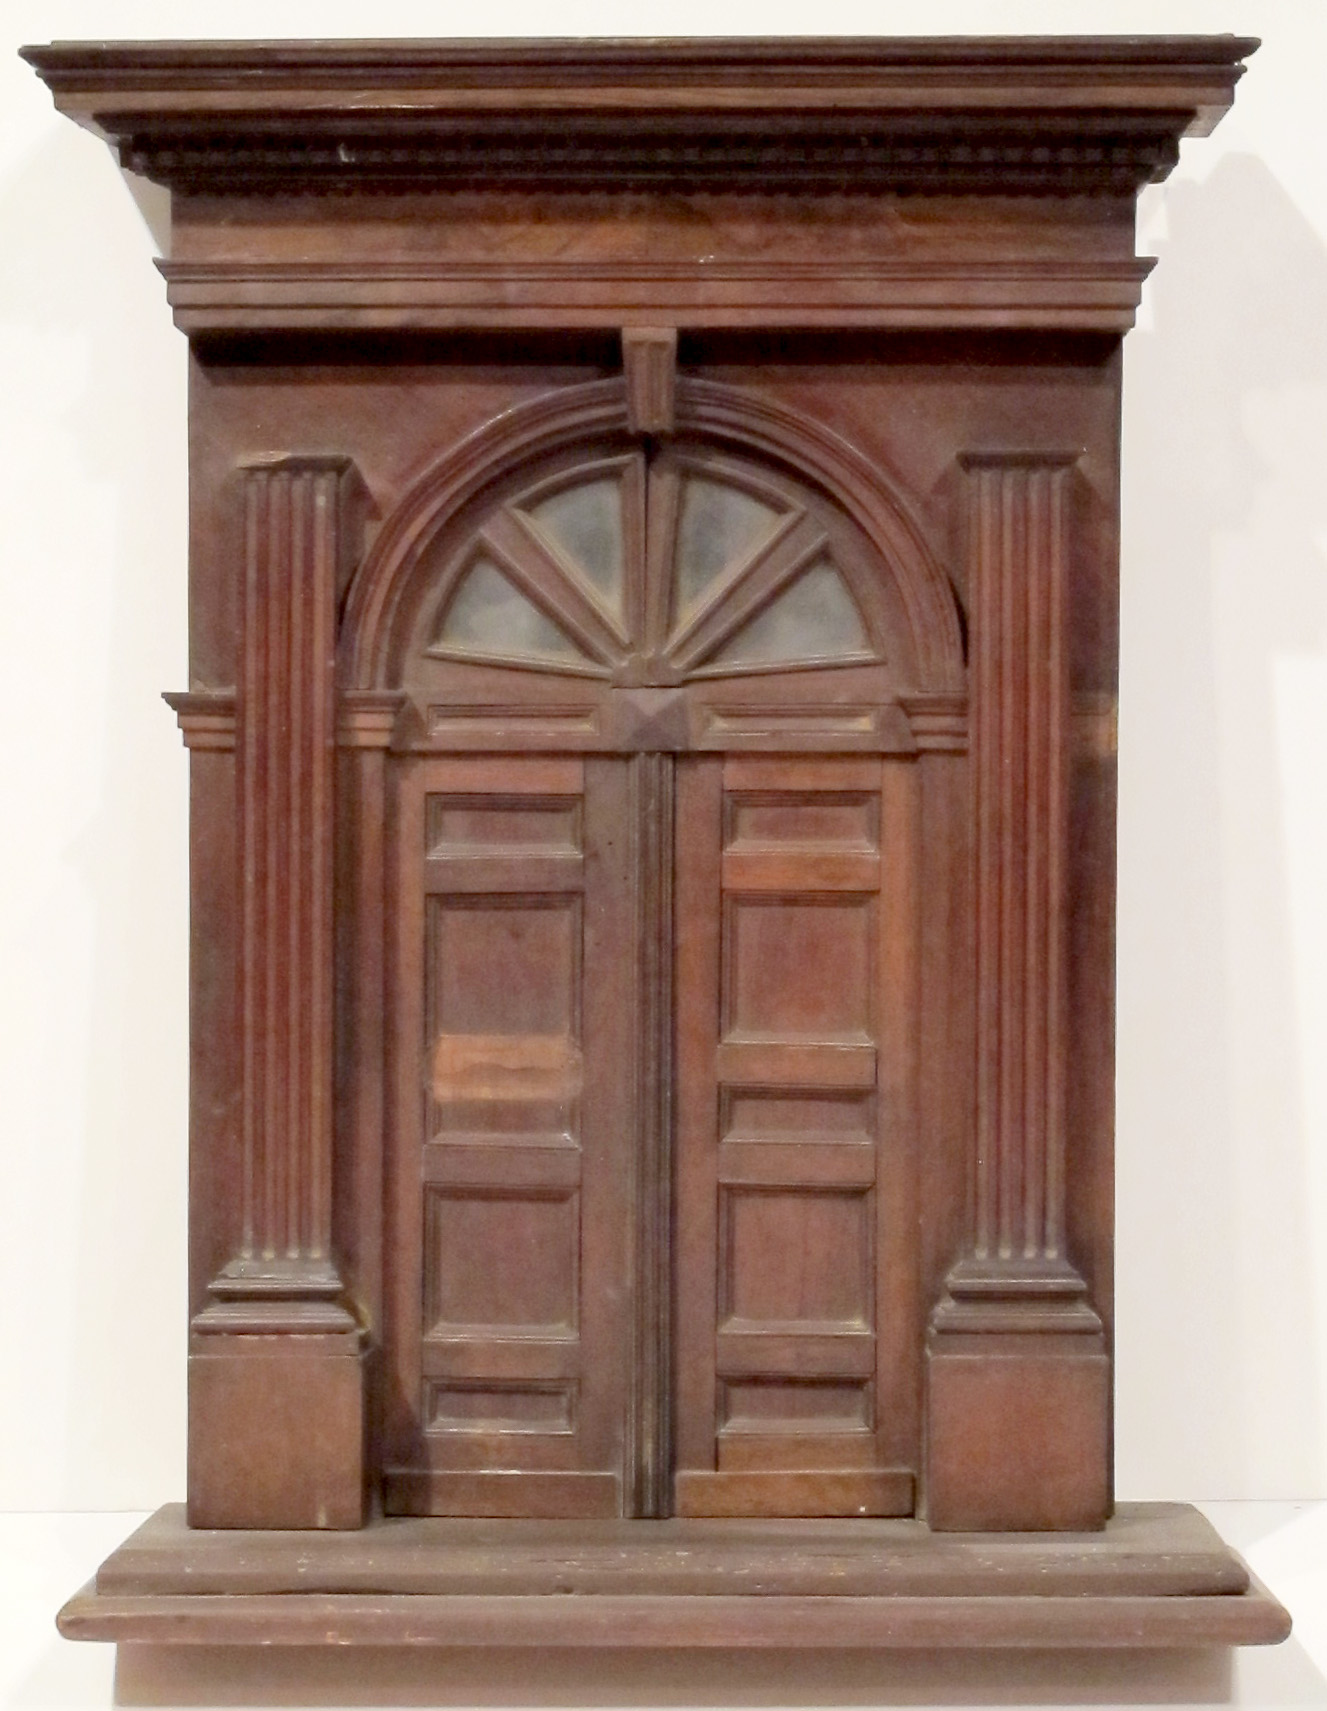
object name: door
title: Miniature door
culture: italian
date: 1601-1700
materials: glass, iron, wood